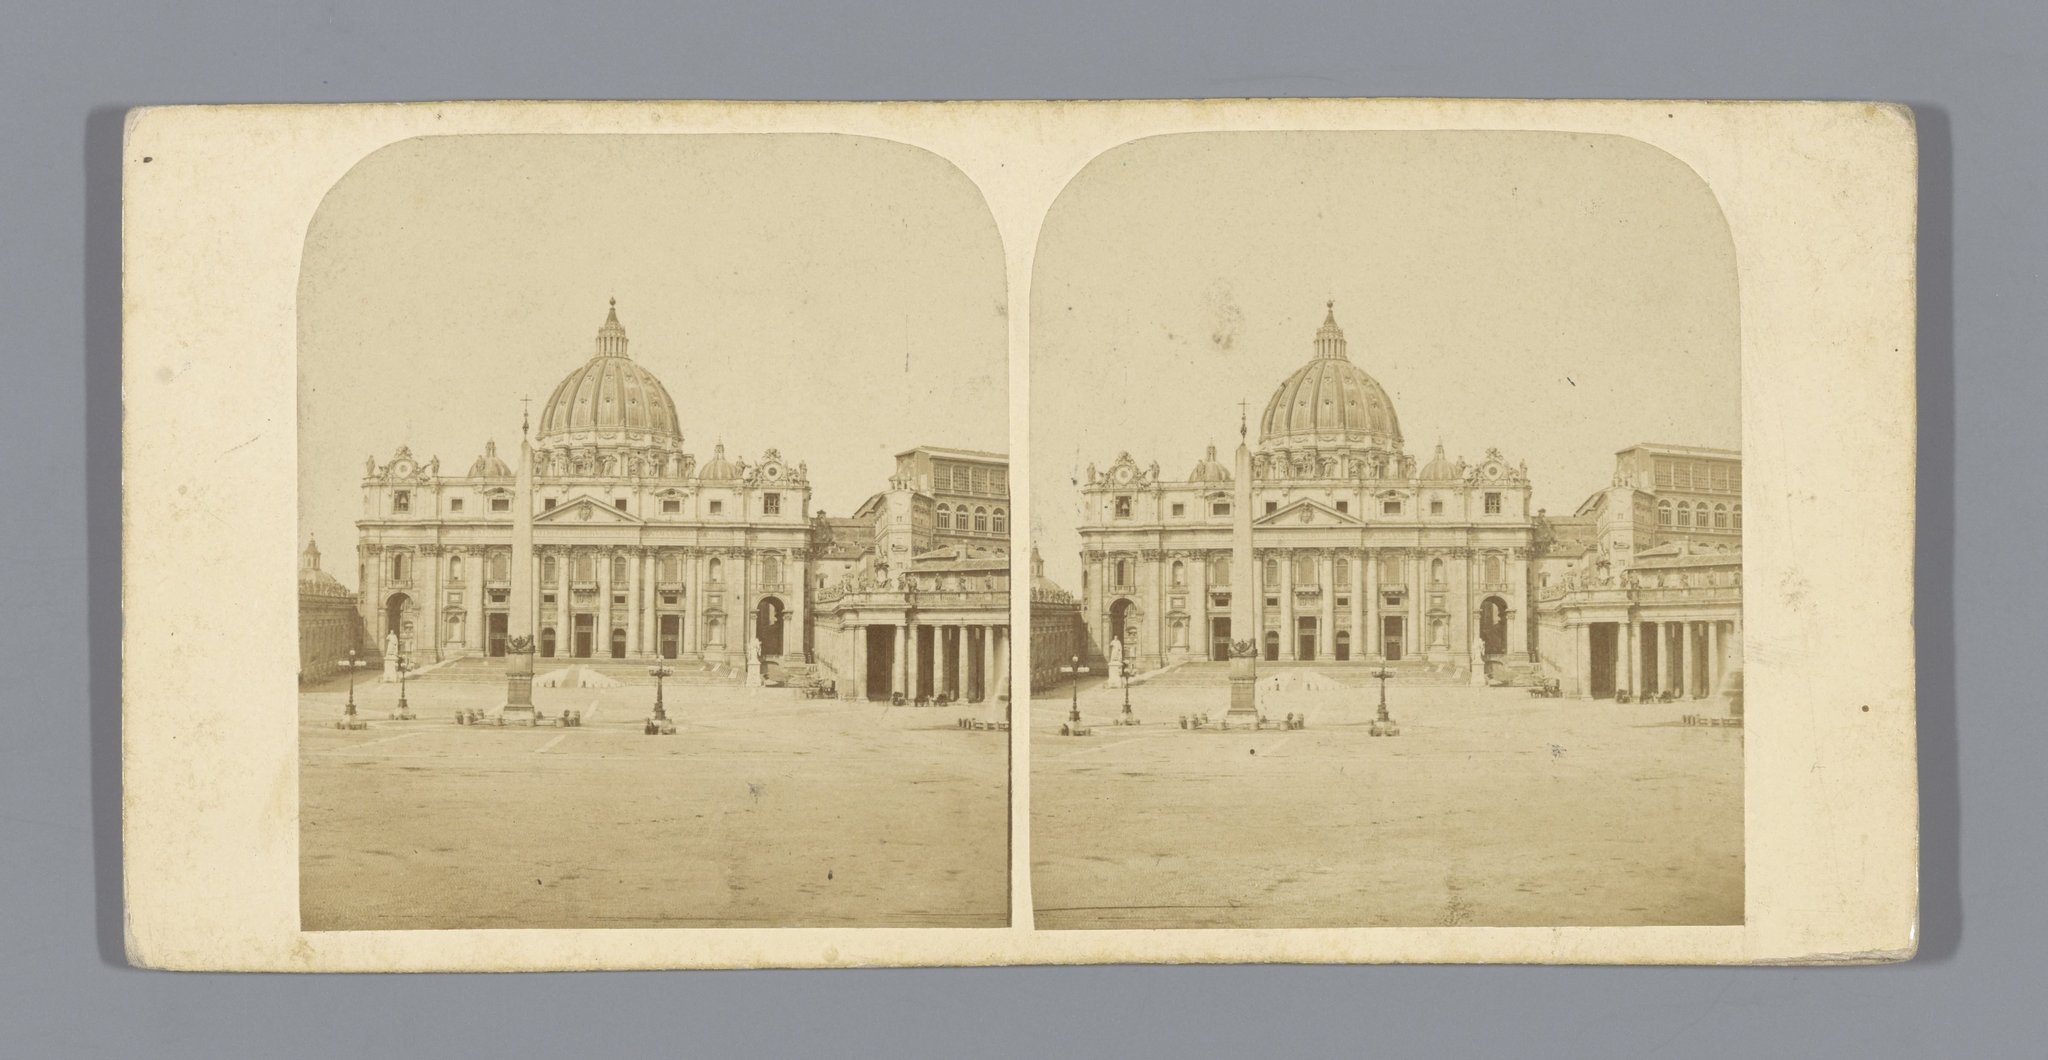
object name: stereograph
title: Gezicht op de Sint-Pieterbasiliek te Vaticaanstad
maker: Anonymous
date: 1850-1880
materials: cardboard, photographic support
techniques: albumen print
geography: sint-pietersplein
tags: obelisk, needle, church (exterior), façade (of house or building)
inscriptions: inscription: ‘St Pierre à Rome’